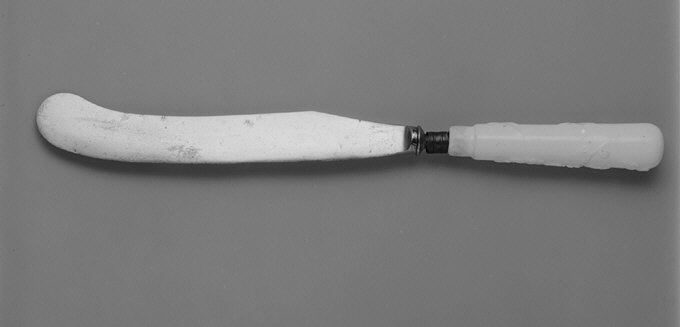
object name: knife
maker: saint-cloud factory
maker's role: factory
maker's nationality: french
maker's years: 1693-1766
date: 1730-1750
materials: soft paste porcelain